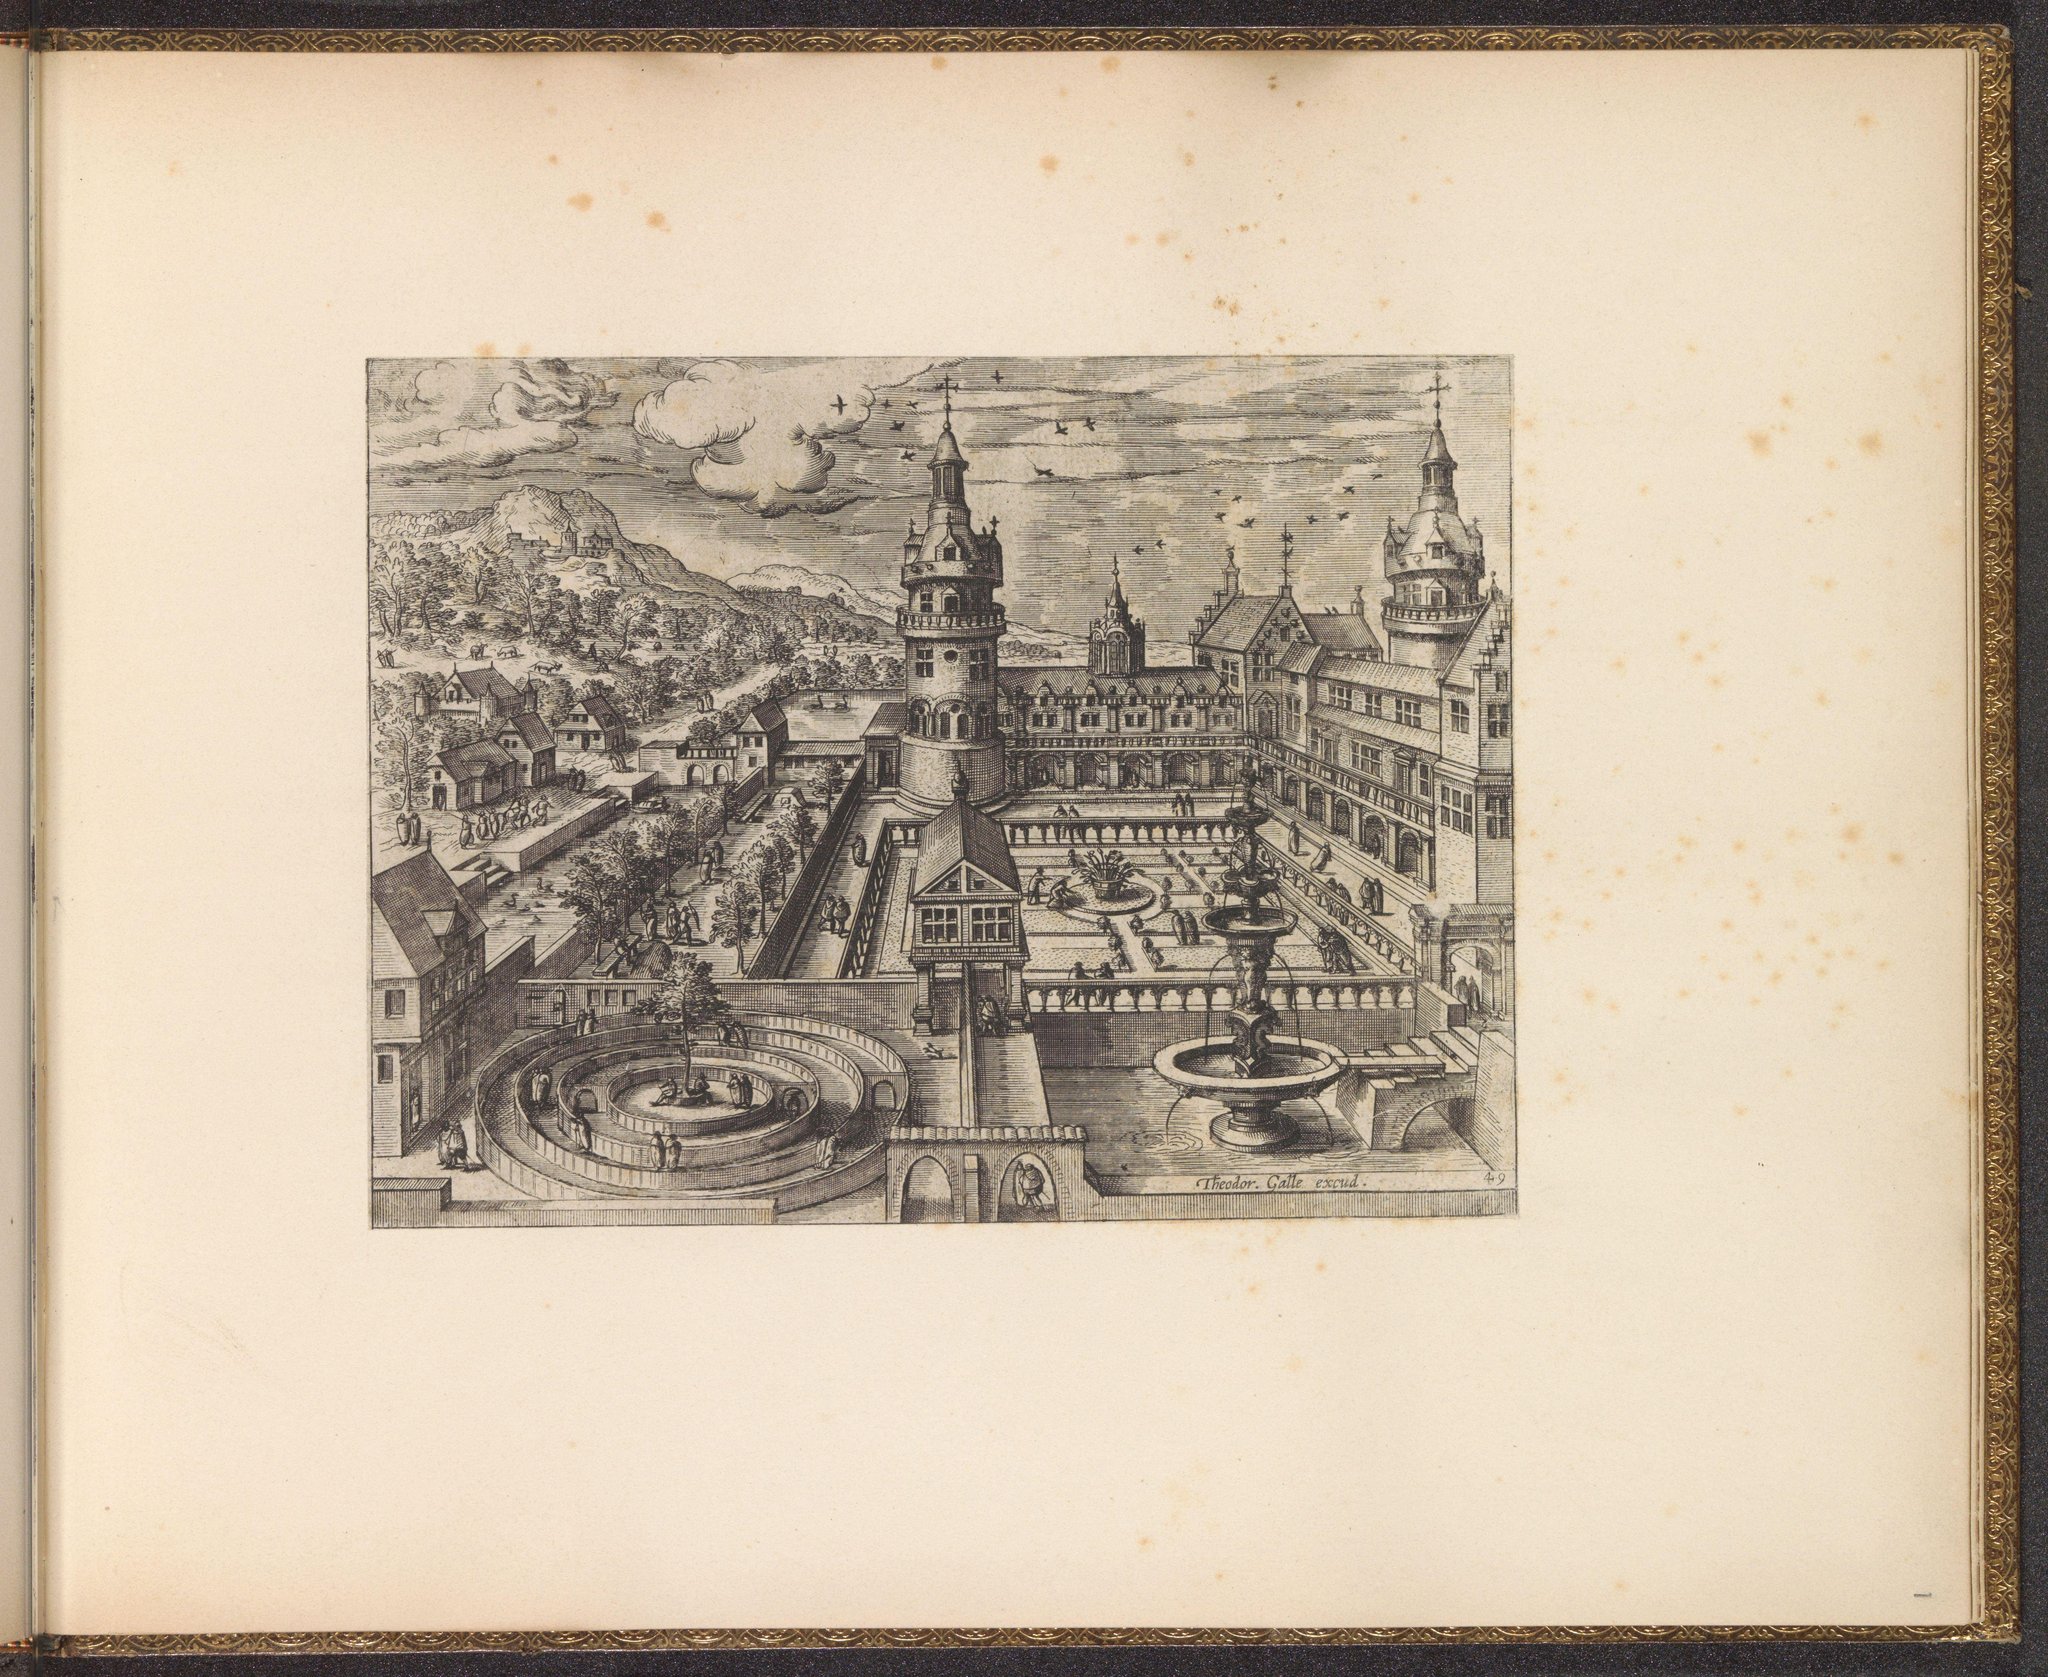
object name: album leaf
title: Paleis met tuinencomplex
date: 1601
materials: paper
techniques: etching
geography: antwerp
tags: garden, garden fountain, palace, labyrinth, maze ~ garden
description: Paleis met een tuinencomplex. Op de voorgrond ligt een eenvoudig labyrint en rechts een bassin met een fontein. De prent maakt deel uit van een album.